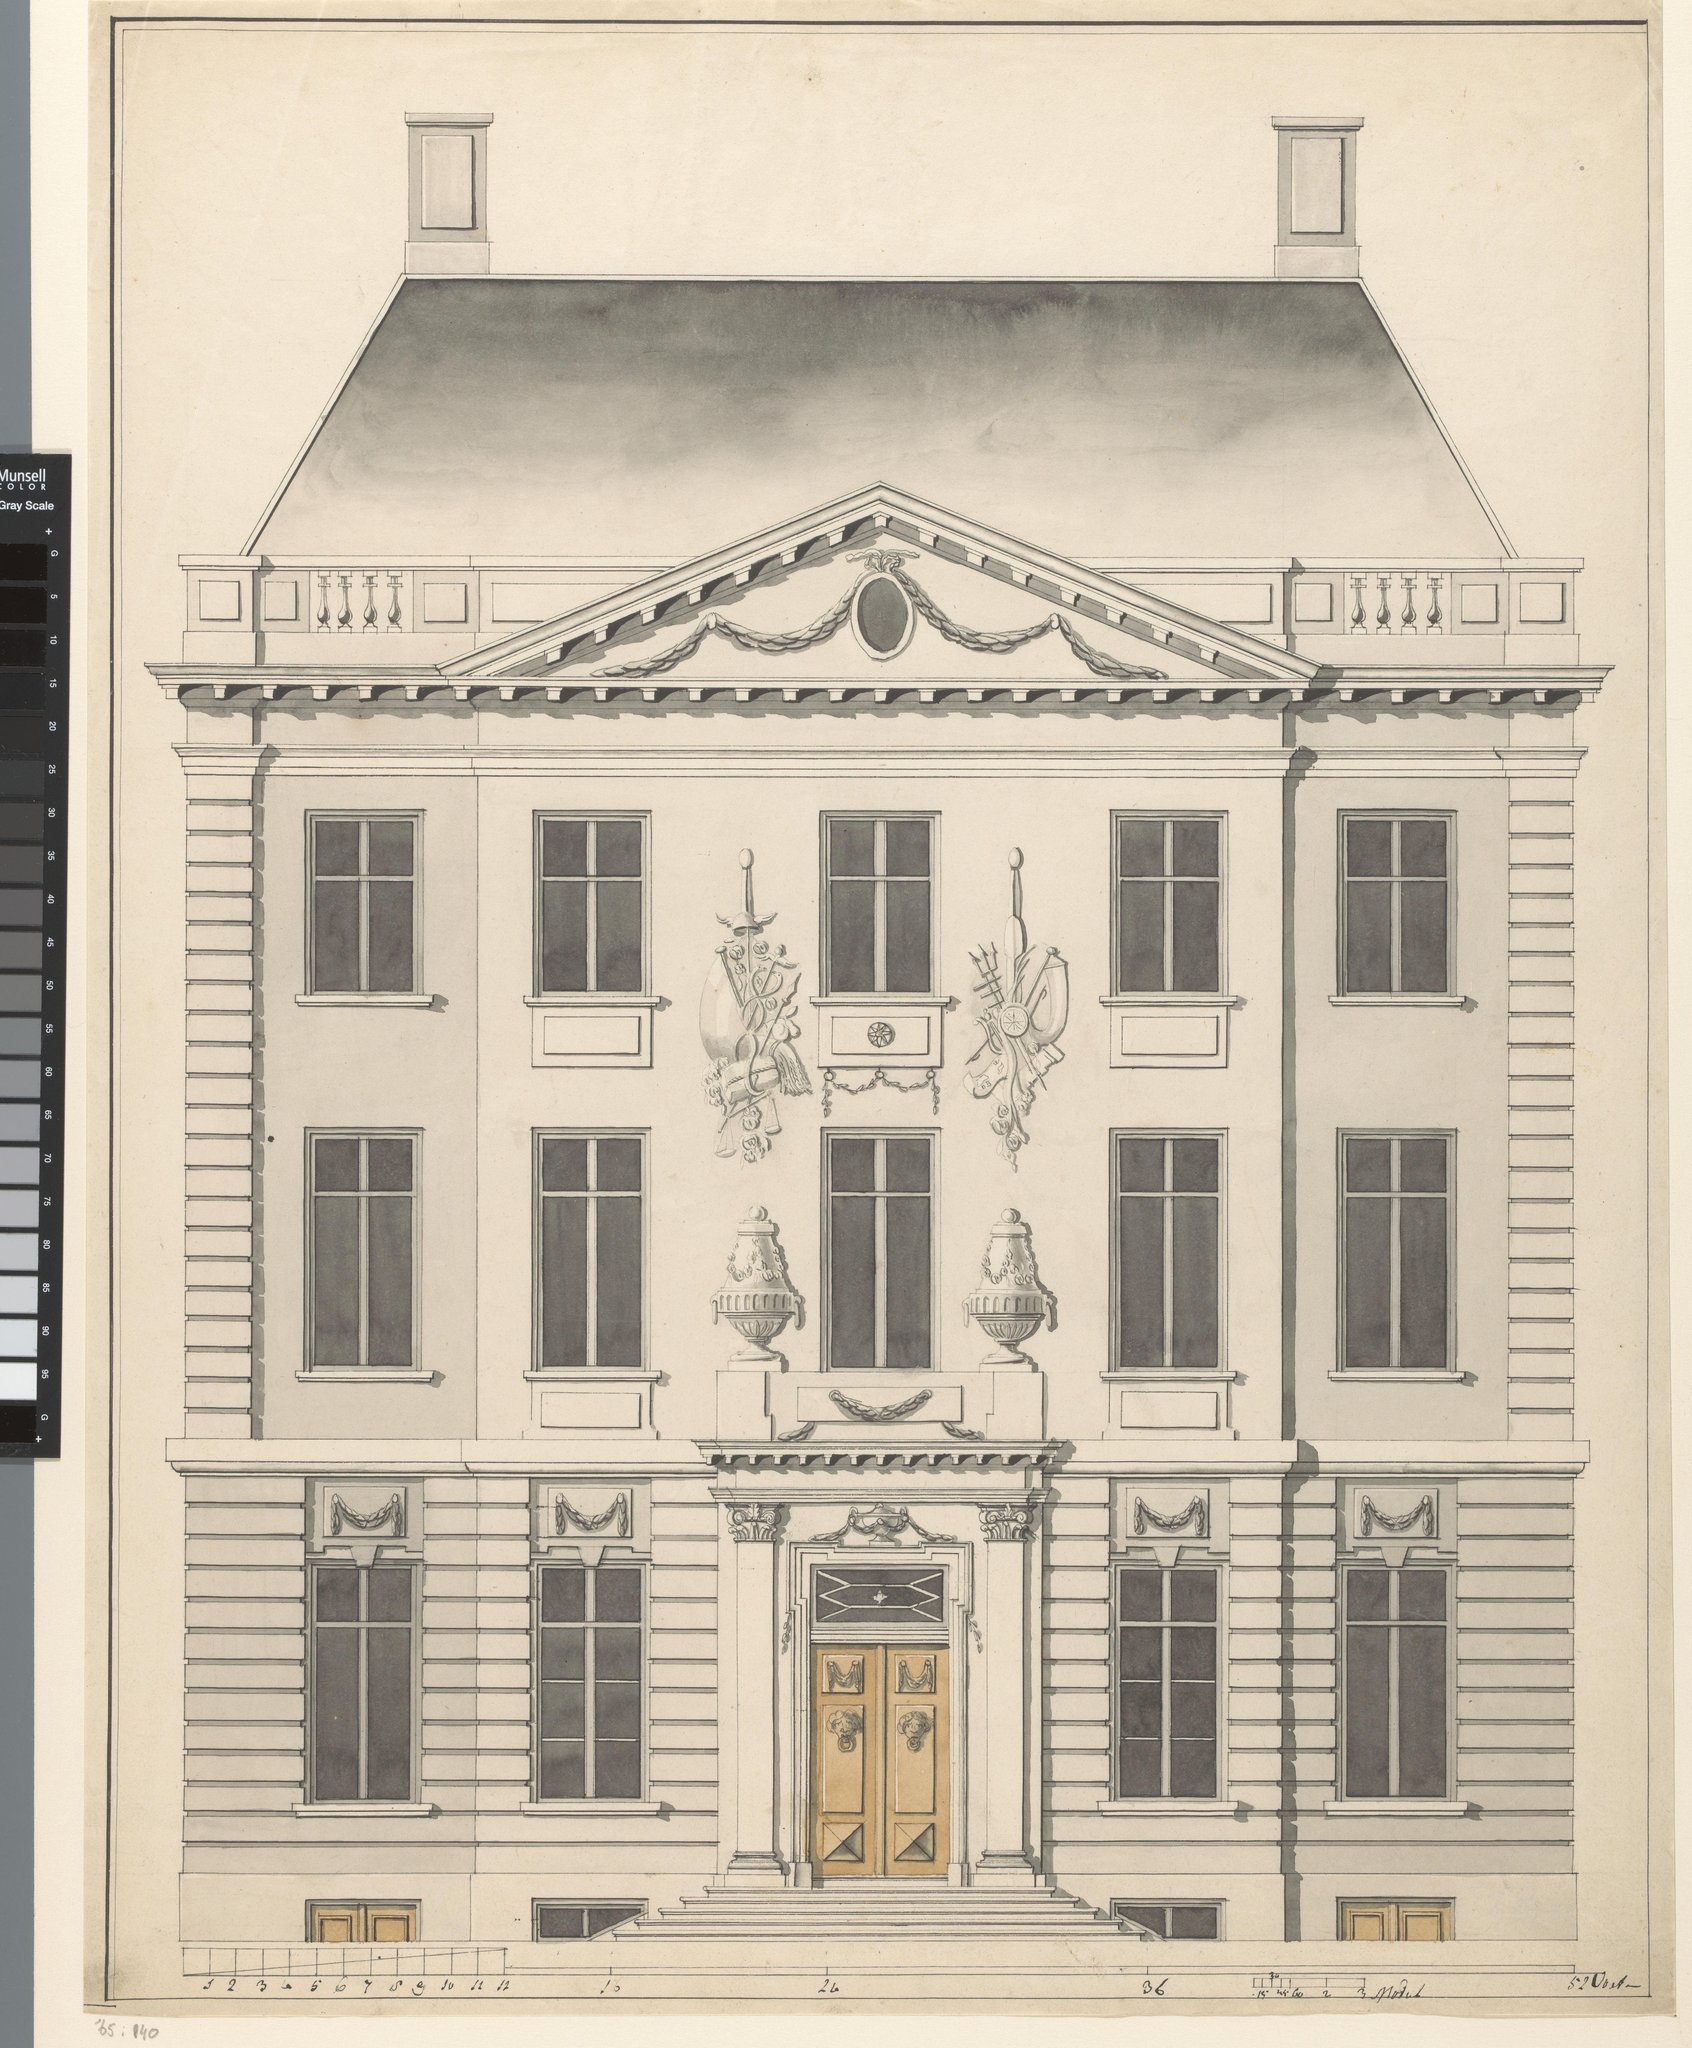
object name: drawing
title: Ontwerp voor een classicistische woonhuisgevel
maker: Anonymous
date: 1700-1799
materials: ink, paper, pencil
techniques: brush, pen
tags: urban housing, façade (of house or building), exterior ~ architectural design or model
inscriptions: collector's mark: Lugt 2228, inscription: ‘(...)’